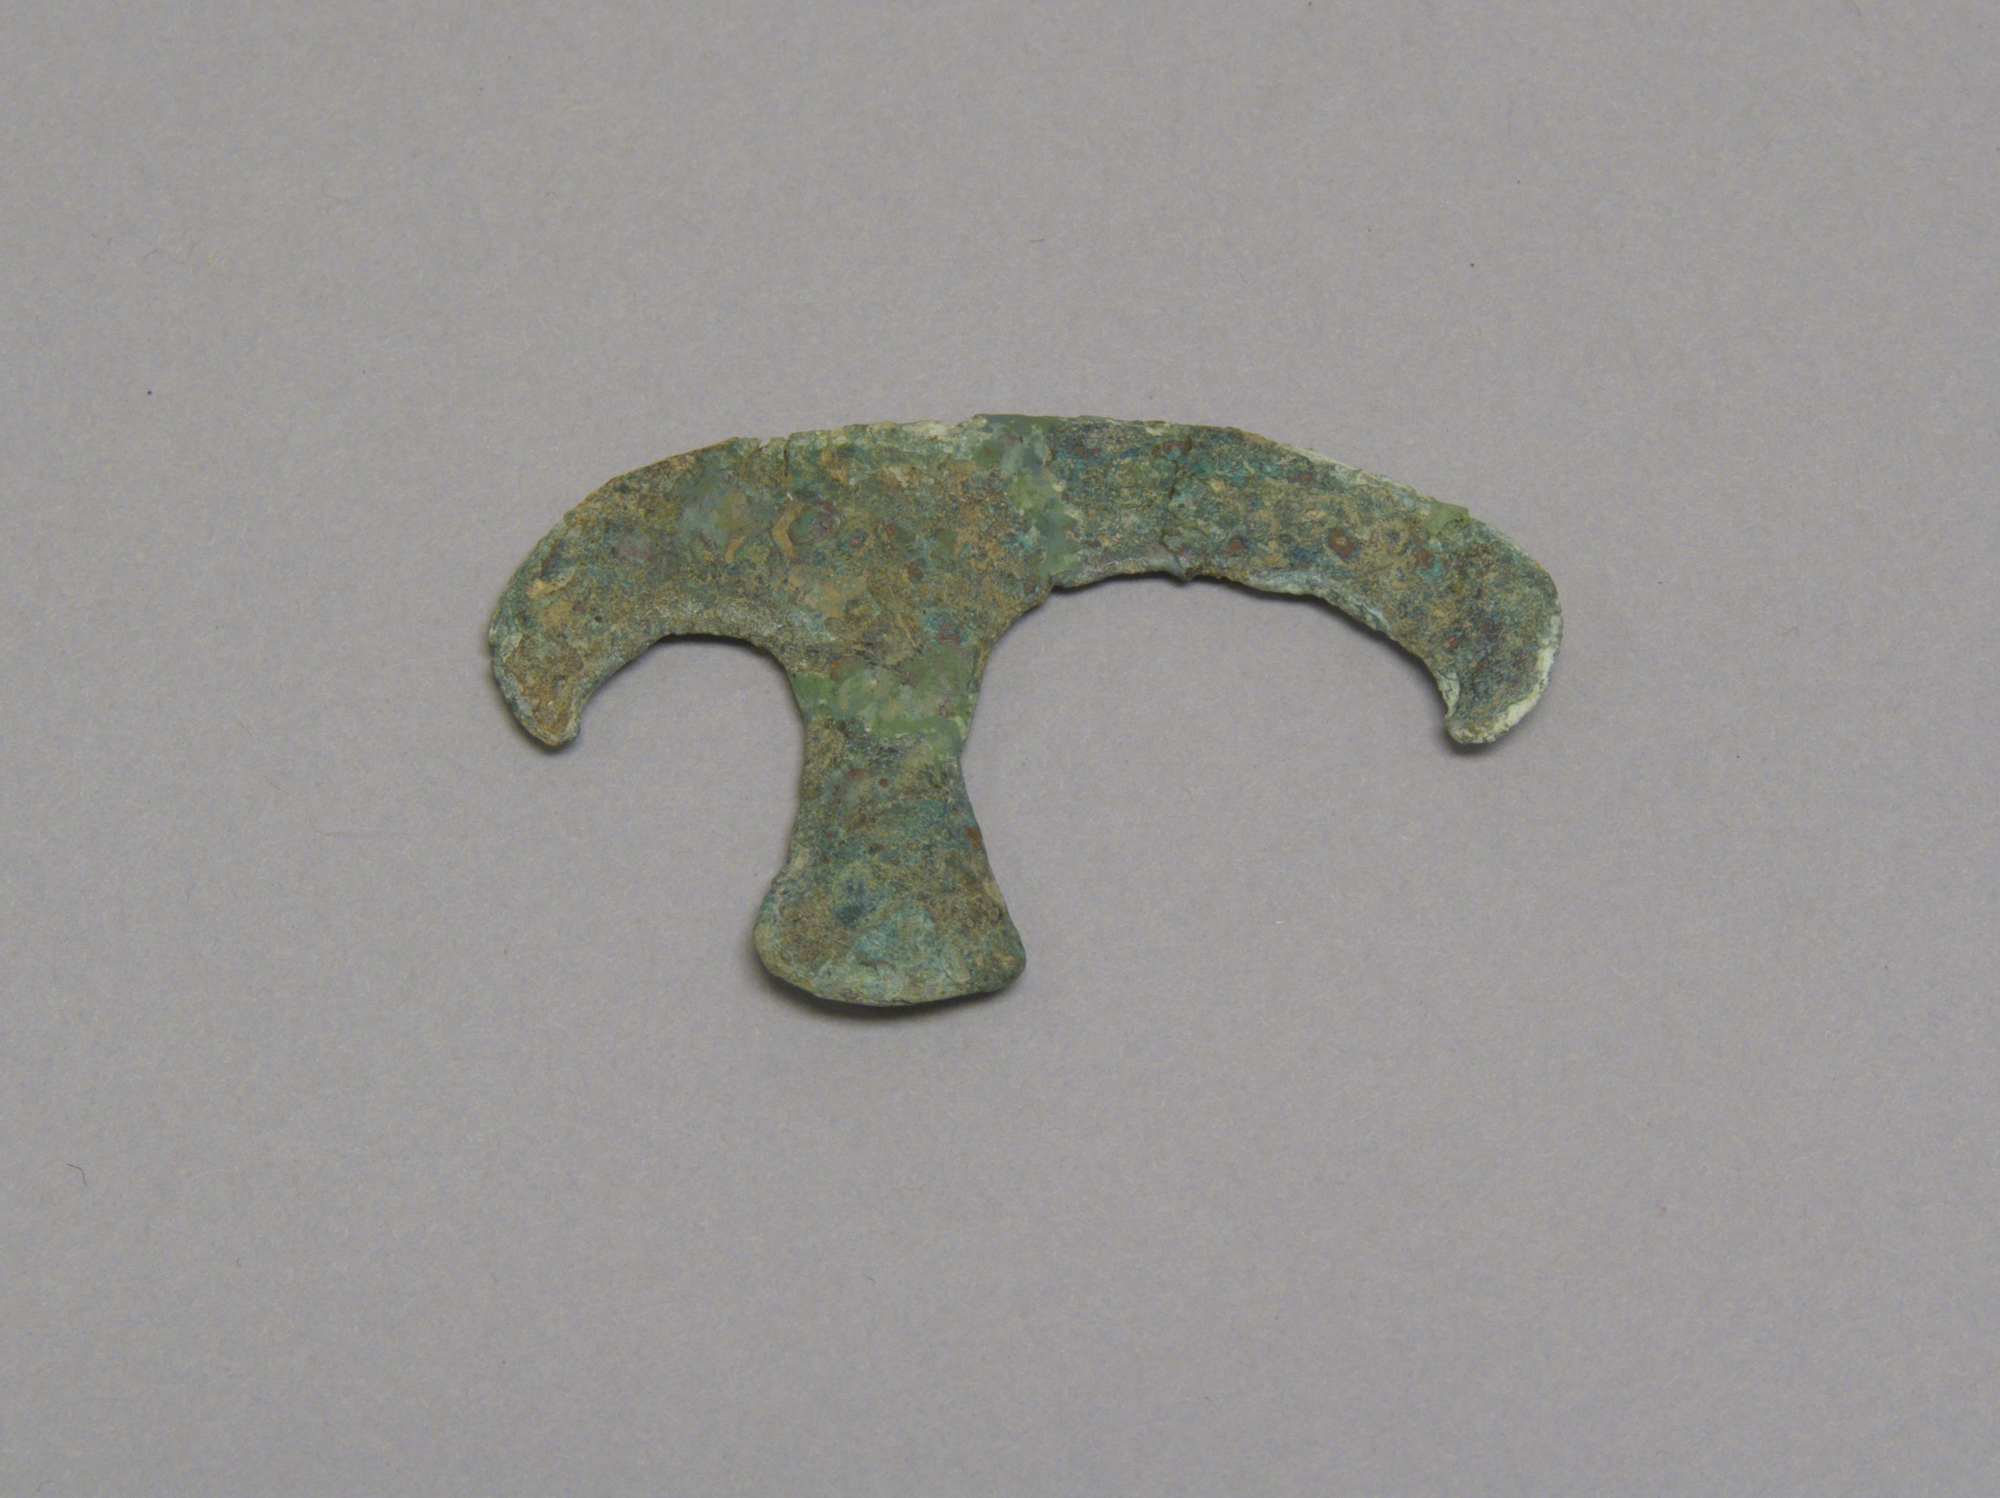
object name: ax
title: Miniature Ax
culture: indonesian, javanese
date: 500 BCE-300 CE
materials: bronze